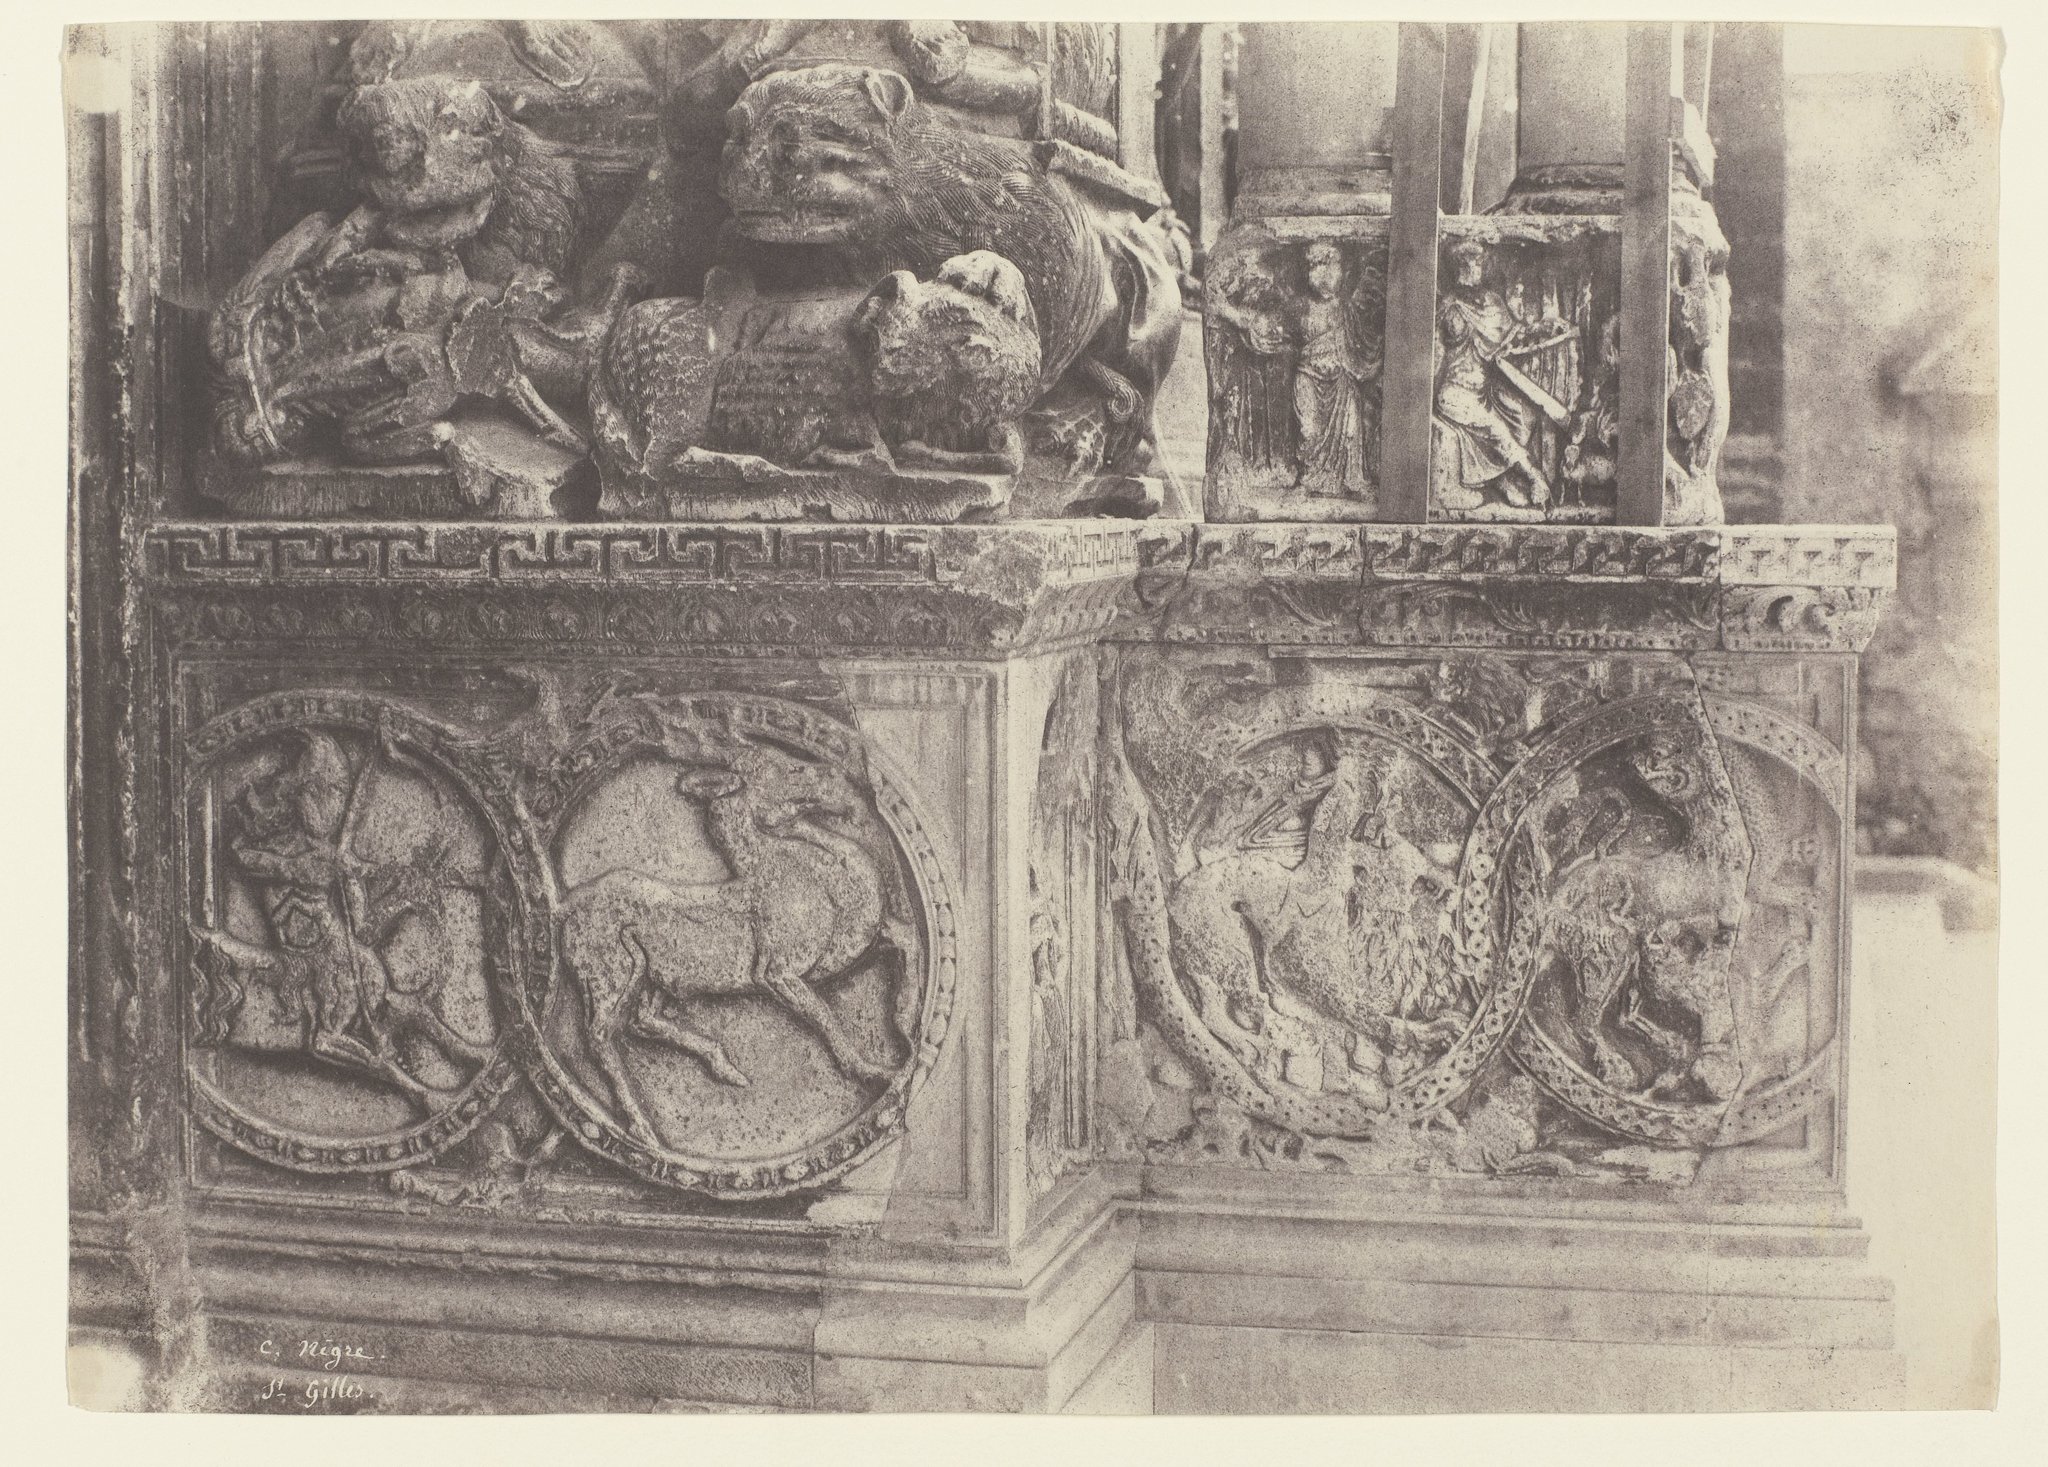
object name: photograph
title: Bas-reliëf aan de kerk van Saint-Gilles-du-Gard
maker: charles nègre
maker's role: fotograaf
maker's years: 1820-1880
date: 1852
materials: paper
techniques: salted paper print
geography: saint-gilles-du-gard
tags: sculpture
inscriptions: signature: ‘C. Nègre./ St. Gilles’, number: ‘265’